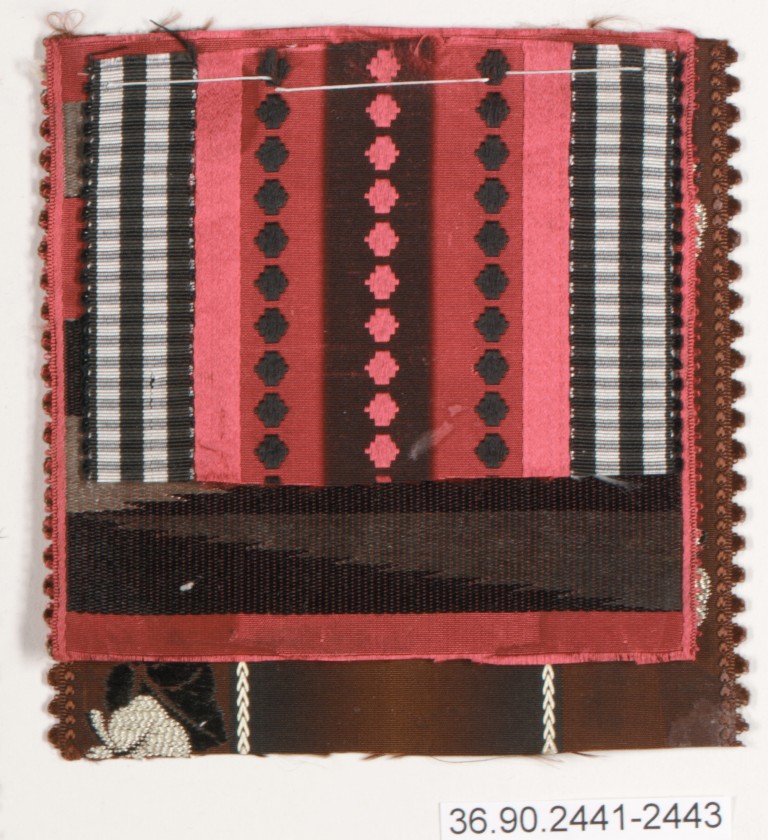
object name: ribbon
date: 1801-1900